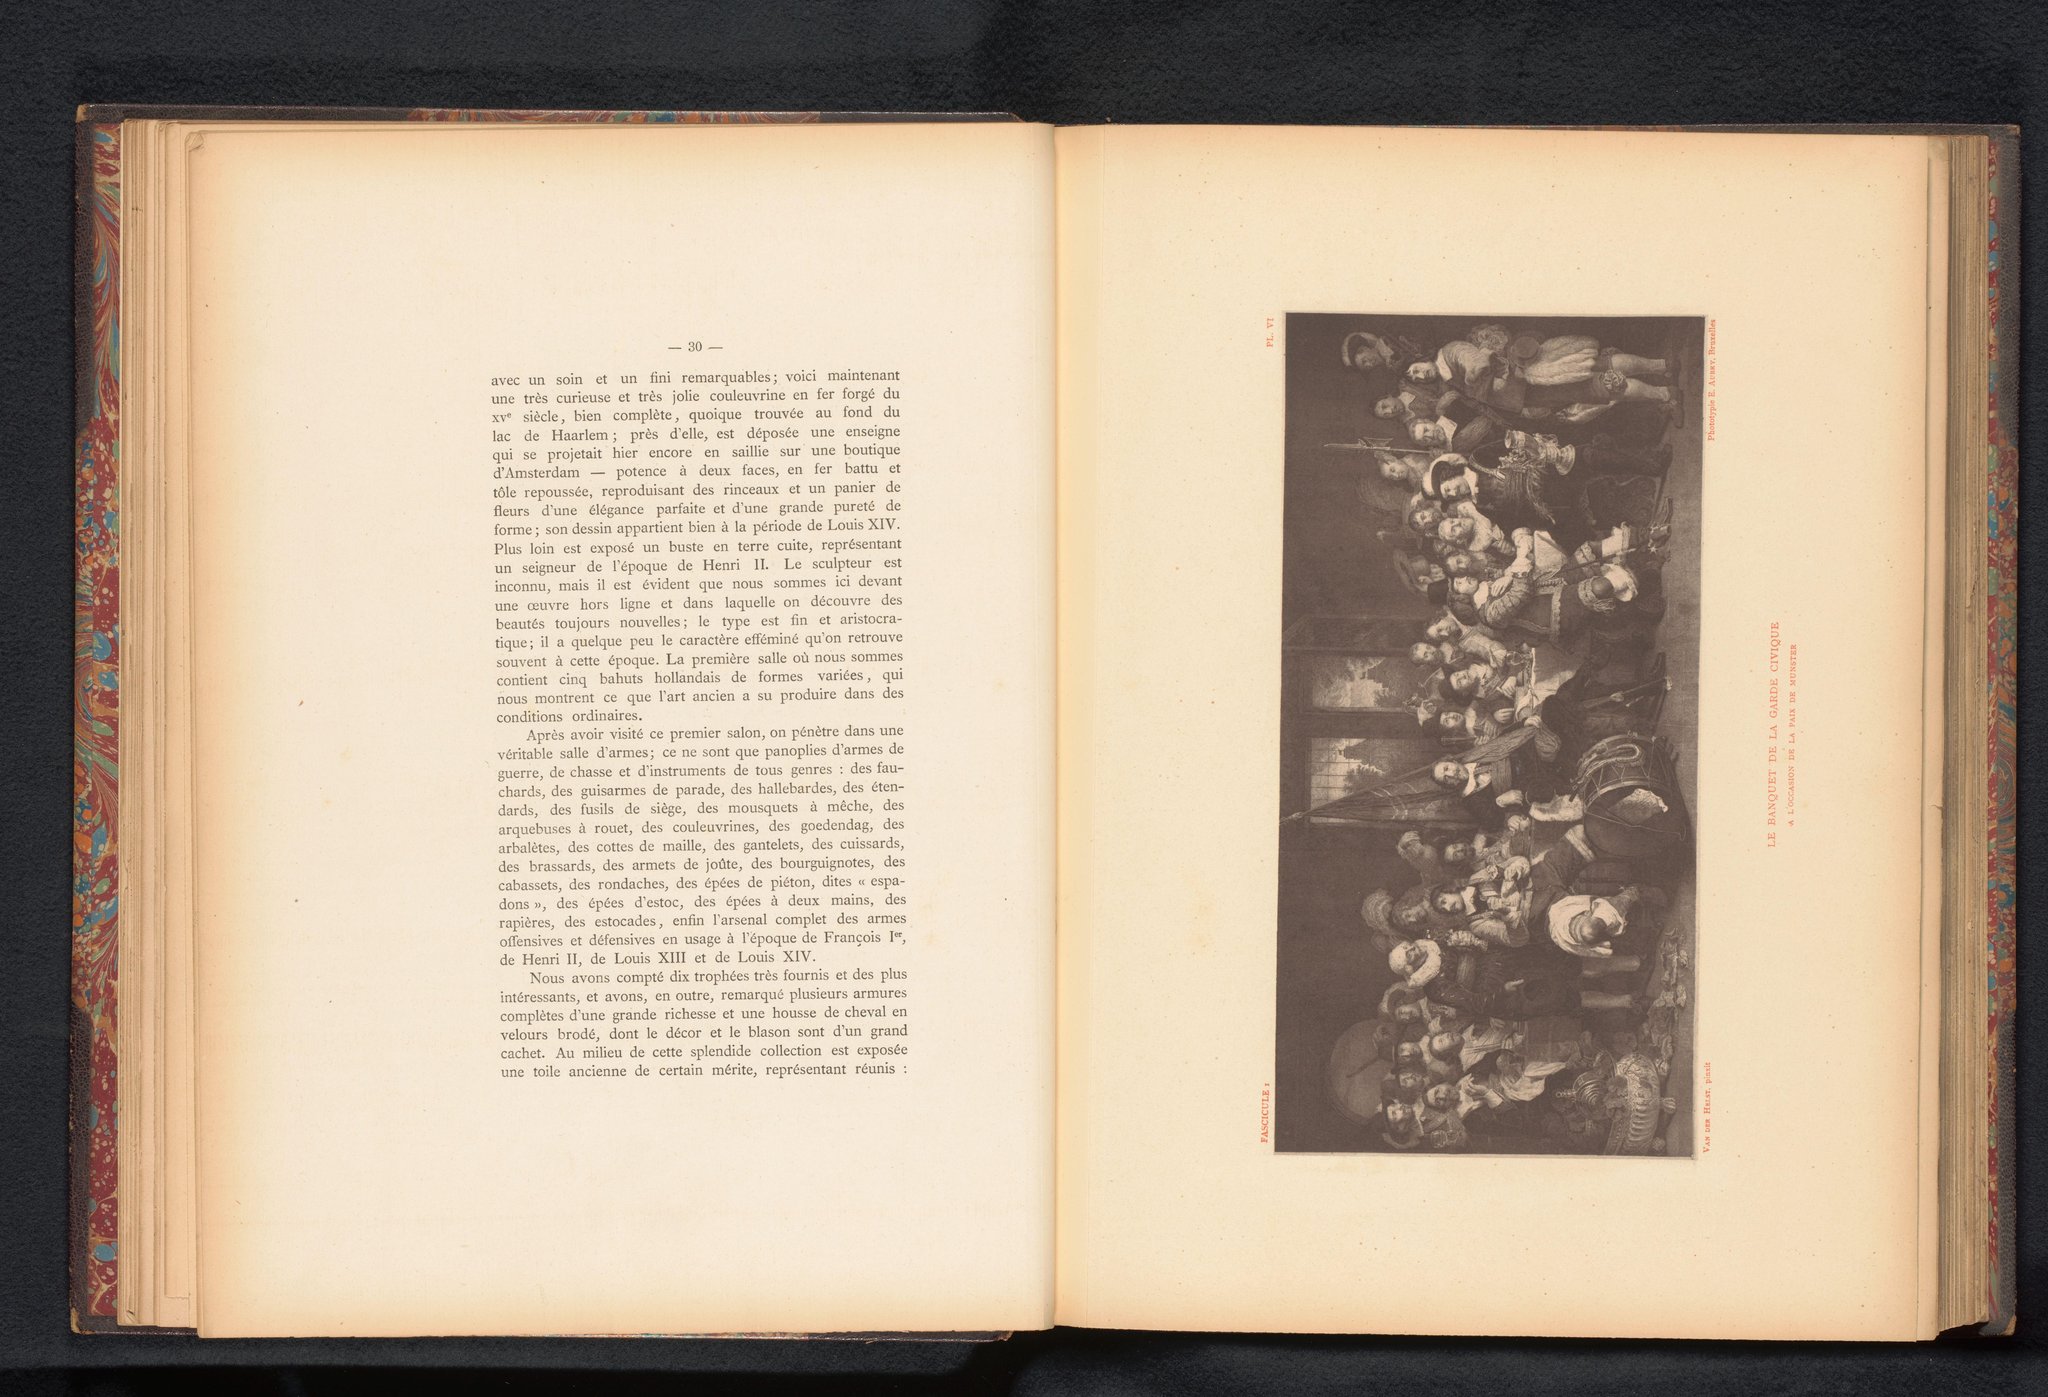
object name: reproduction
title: Le banquet de la garde civique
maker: emile aubry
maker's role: print maker, printer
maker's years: 1829-1900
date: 1878-1883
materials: paper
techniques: photograph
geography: brussels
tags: celebration meal, feast, banquet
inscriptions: inscription: ‘a l'occasion de la paix de munster’, inscription: ‘Fascicule I/ PL. VI’